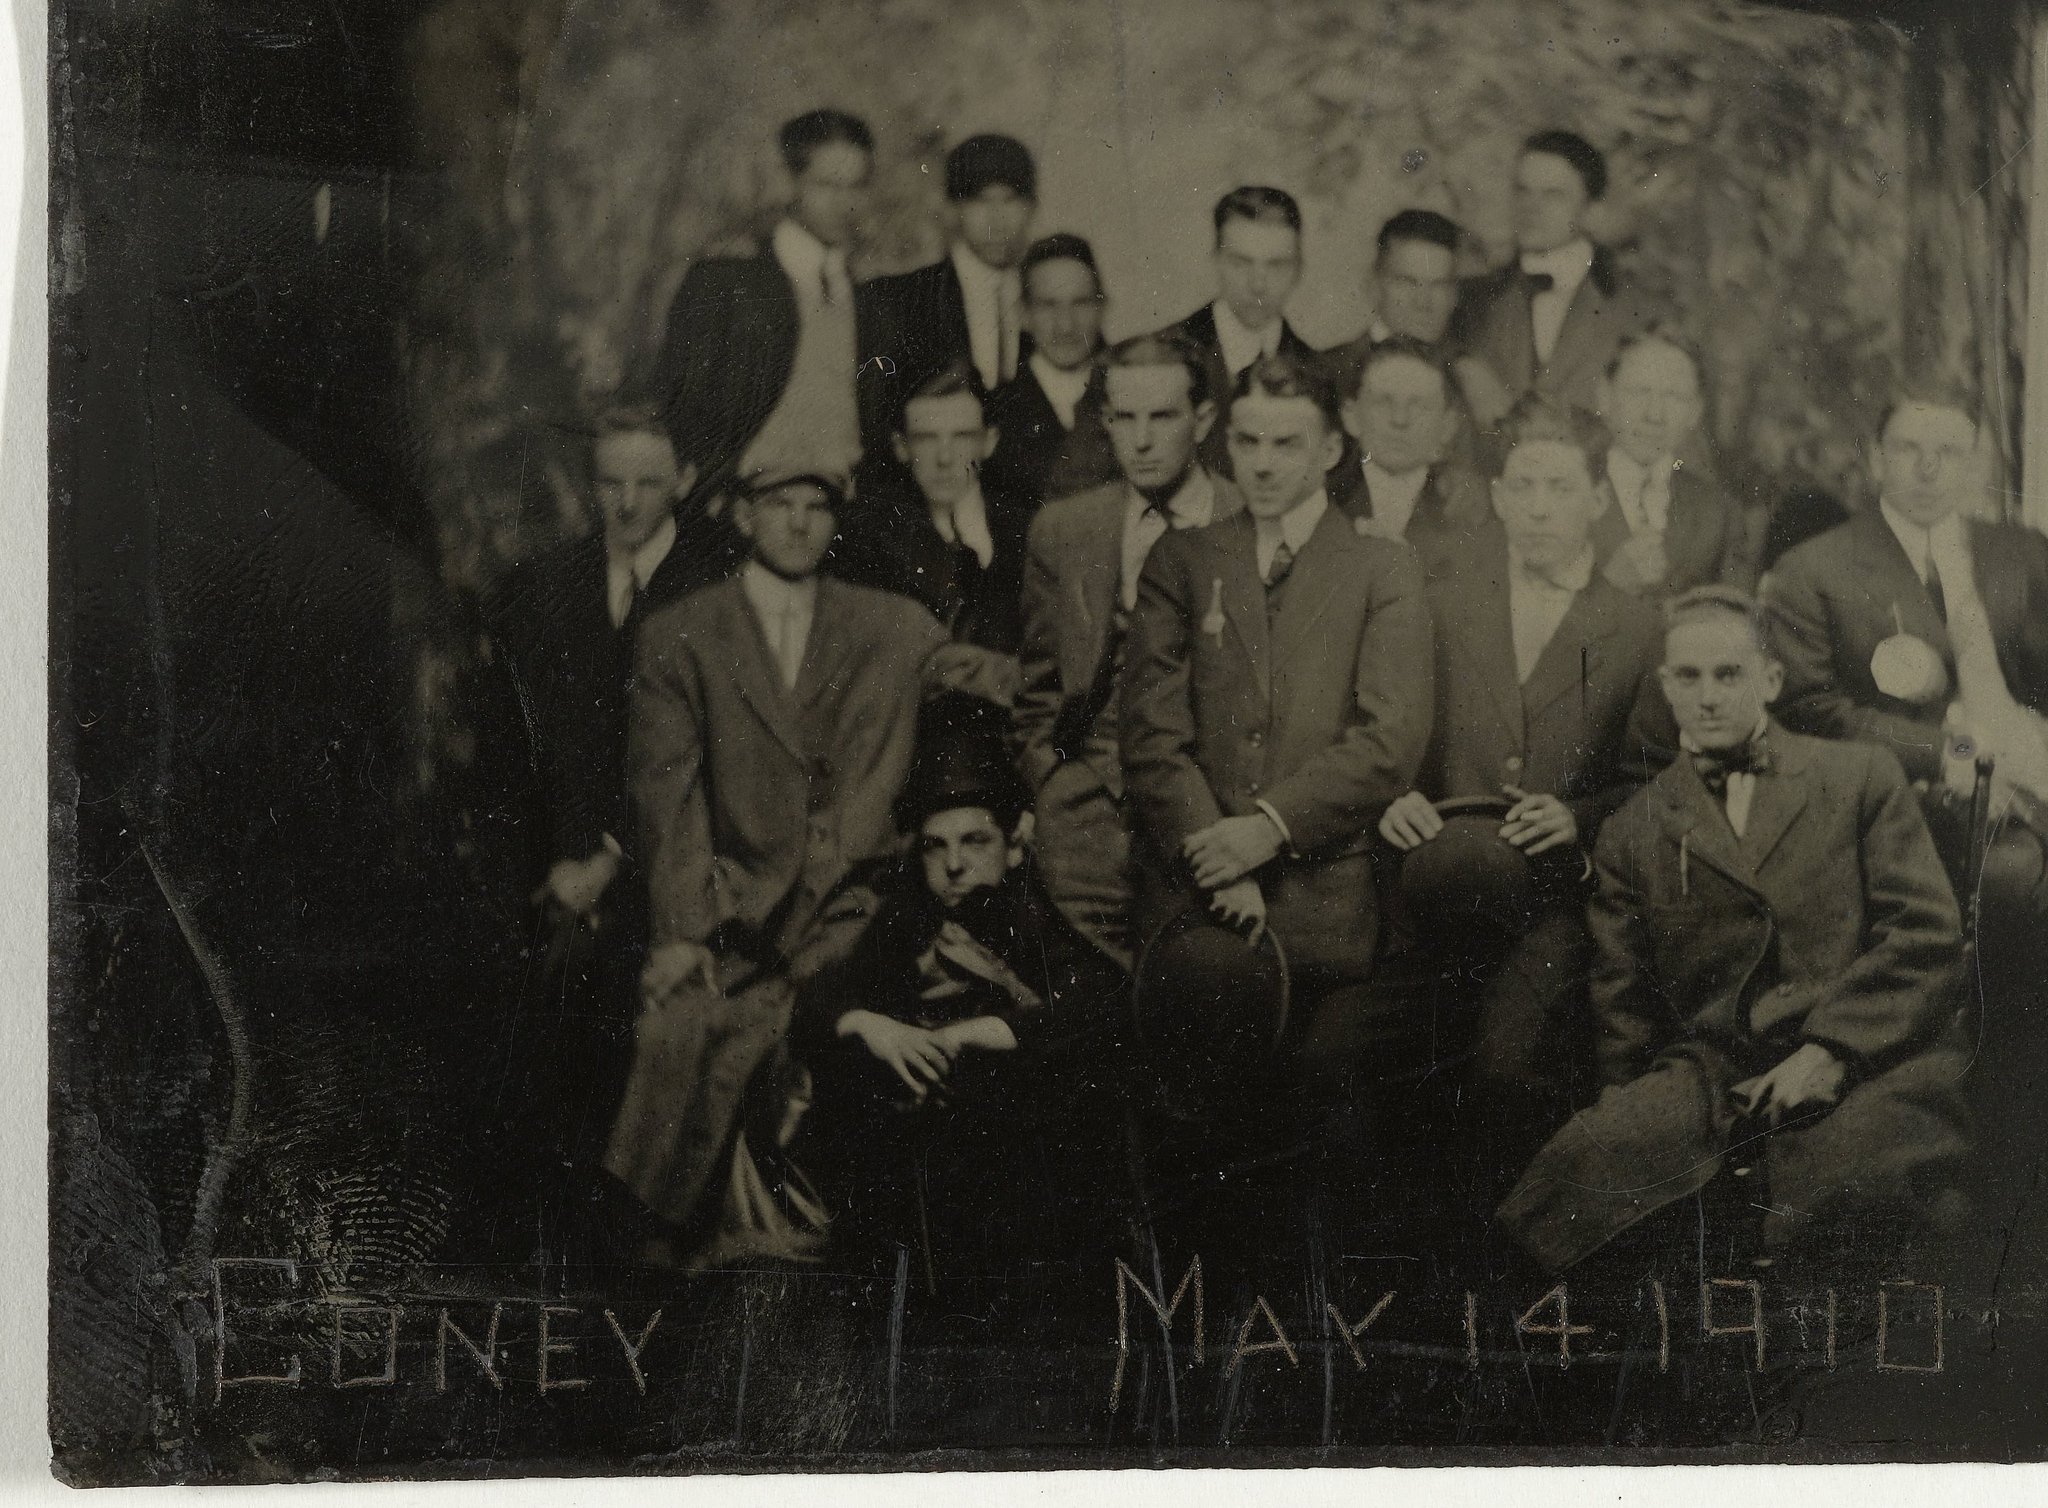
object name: photograph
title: Groepsportret van zeventien mannen voor een geschilderd achtergronddoek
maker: Anonymous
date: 1910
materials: metal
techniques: ferrotyping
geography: coney island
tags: anonymous historical person portrayed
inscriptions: annotation: ‘CONEY MAY 14 1910’